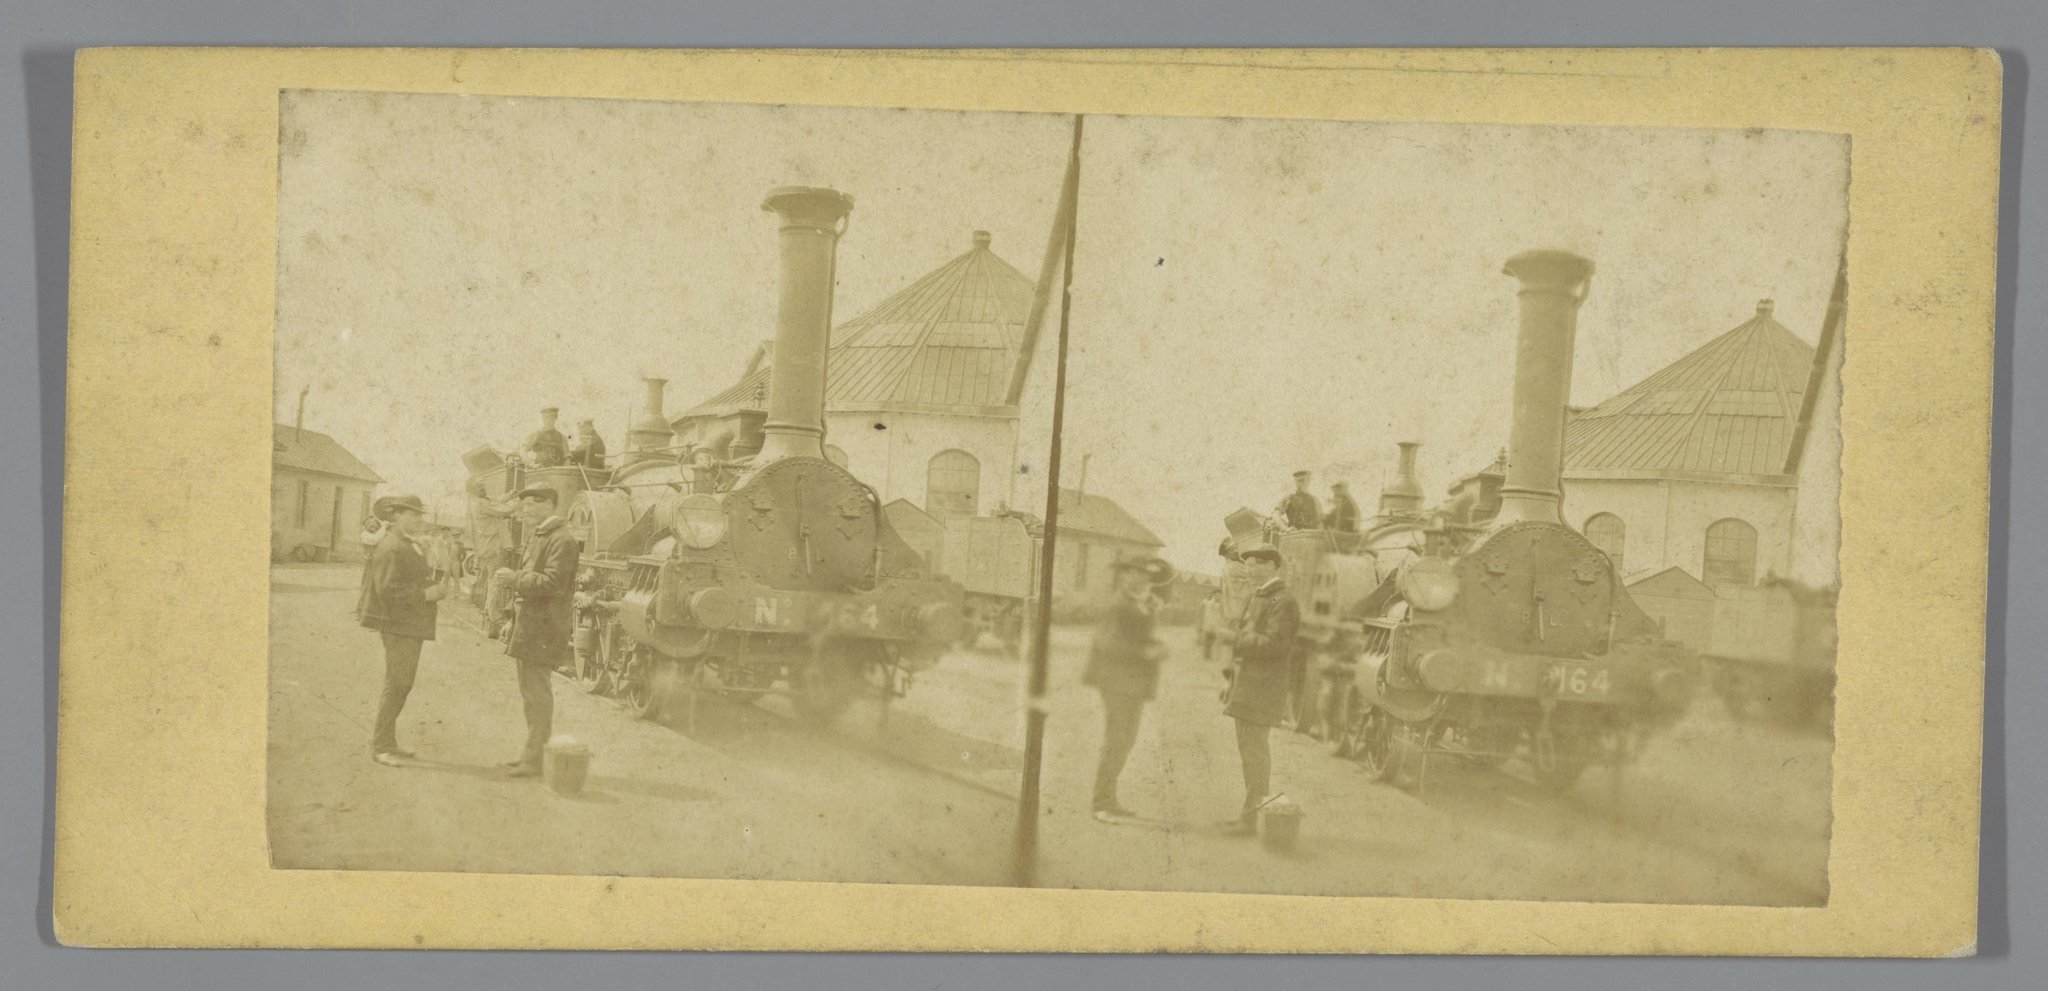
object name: stereograph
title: Stoomlocomotief met machinisten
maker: Anonymous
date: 1857-1870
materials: cardboard, paper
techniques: albumen print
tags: railway, train, steam locomotive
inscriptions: inscription: ‘N. 9/ f 25’